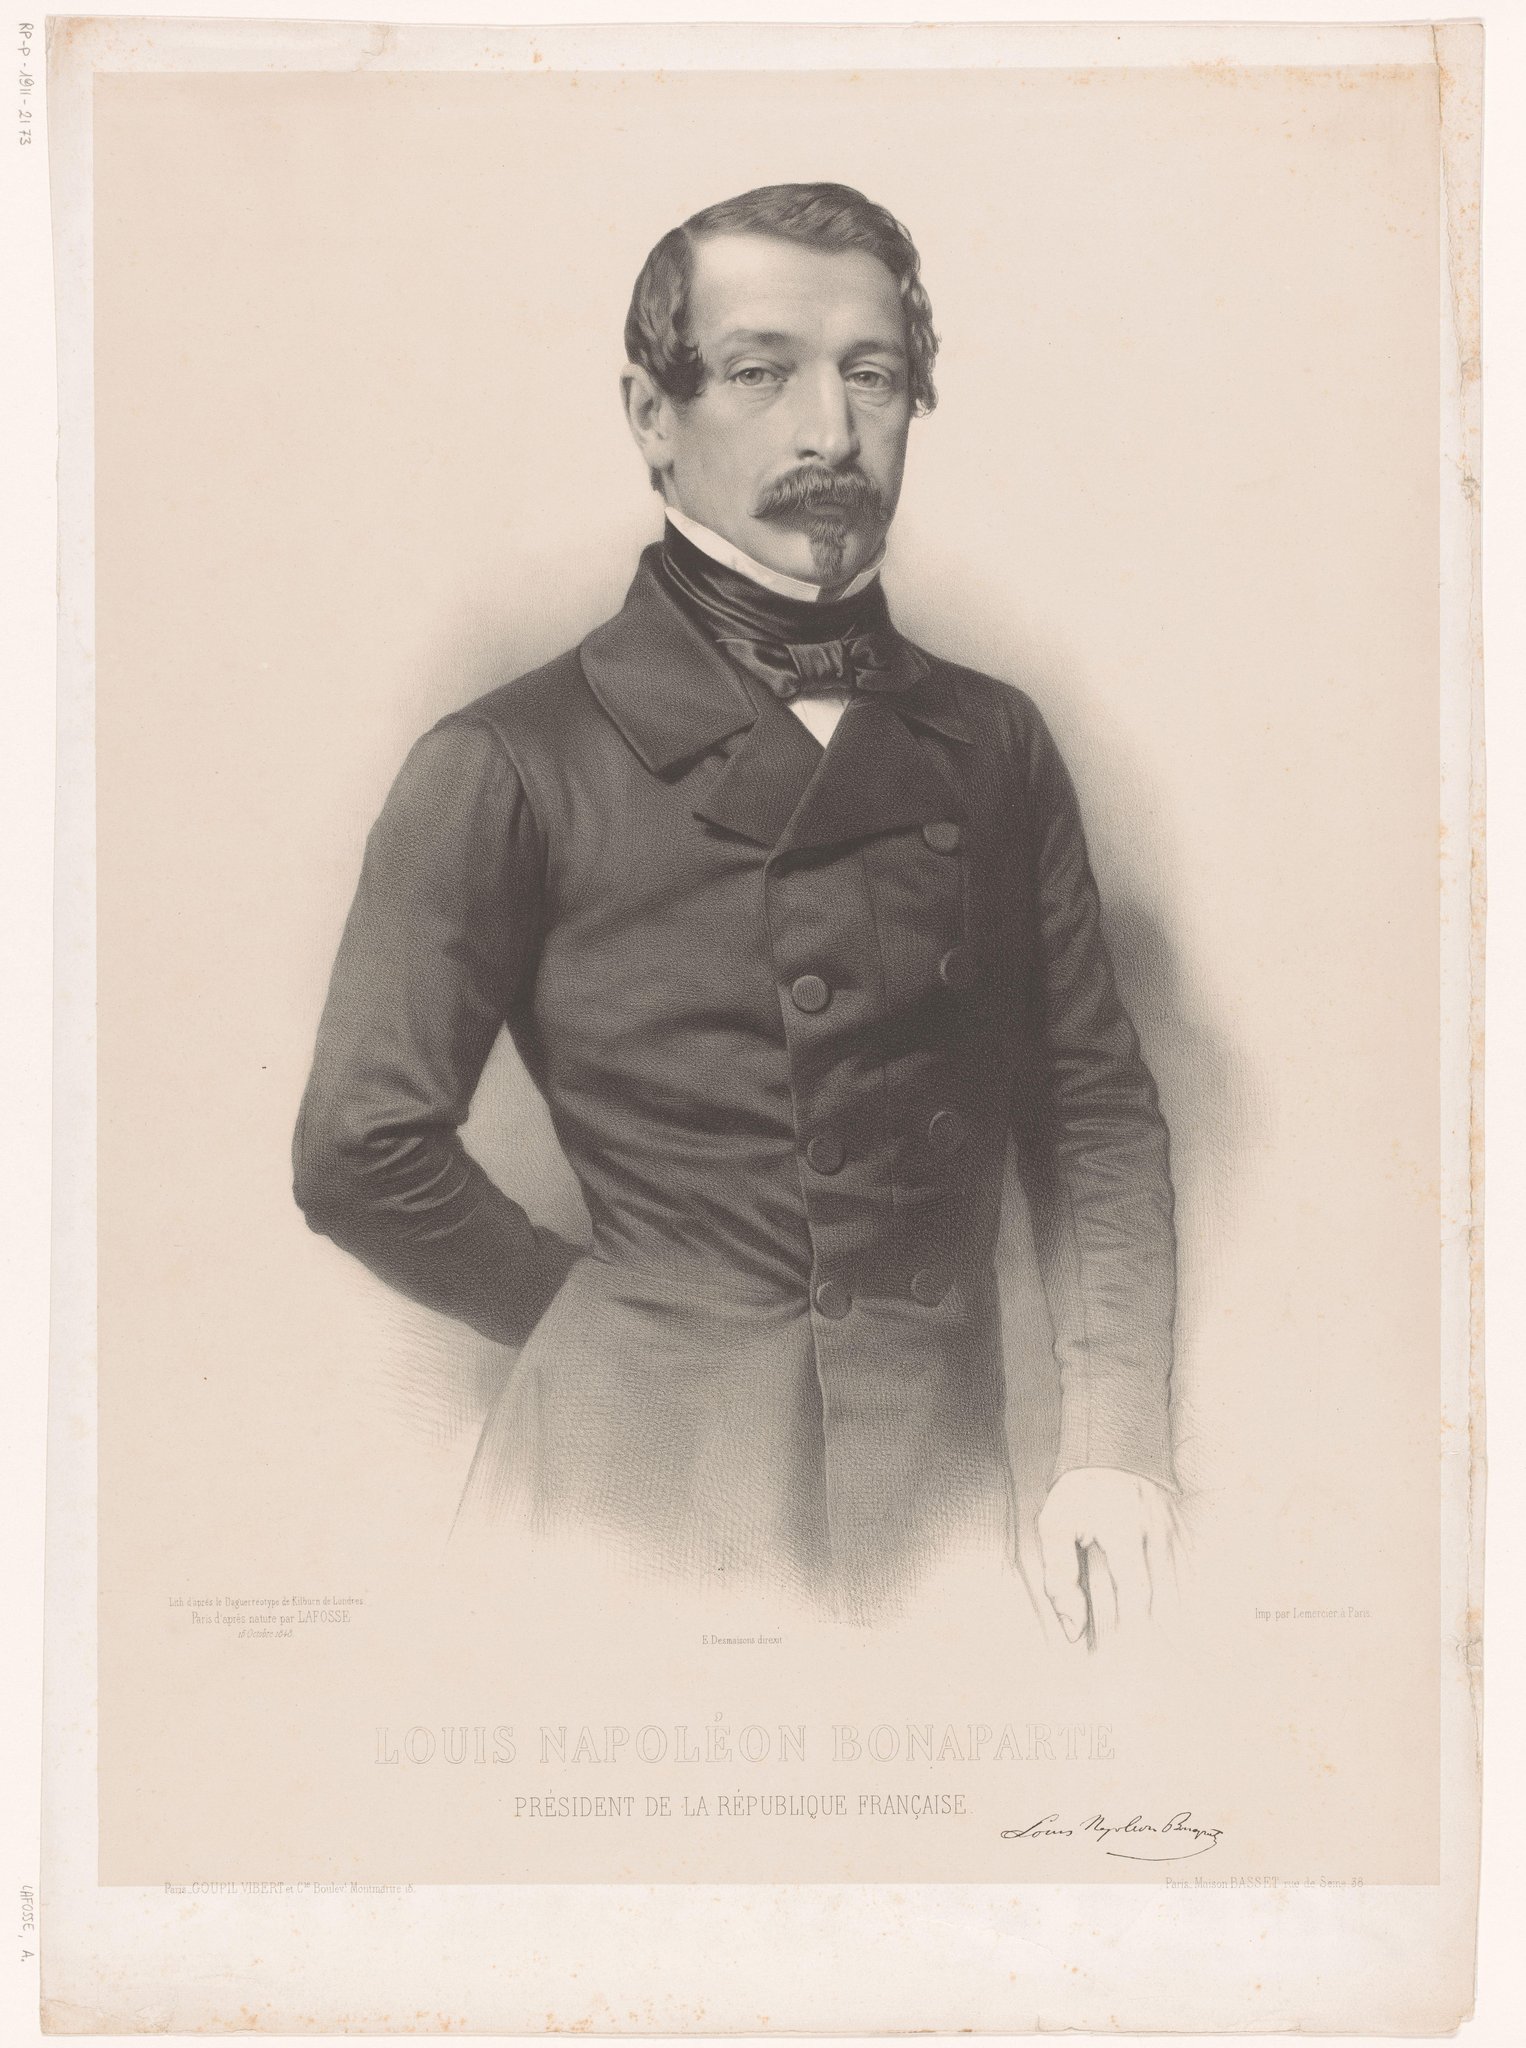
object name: print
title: Portret van Napoleon III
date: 1848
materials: paper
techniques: lithograph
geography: paris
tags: paris, napoleon iii (keizer der fransen), historical persons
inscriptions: collector's mark: Lugt 2228a